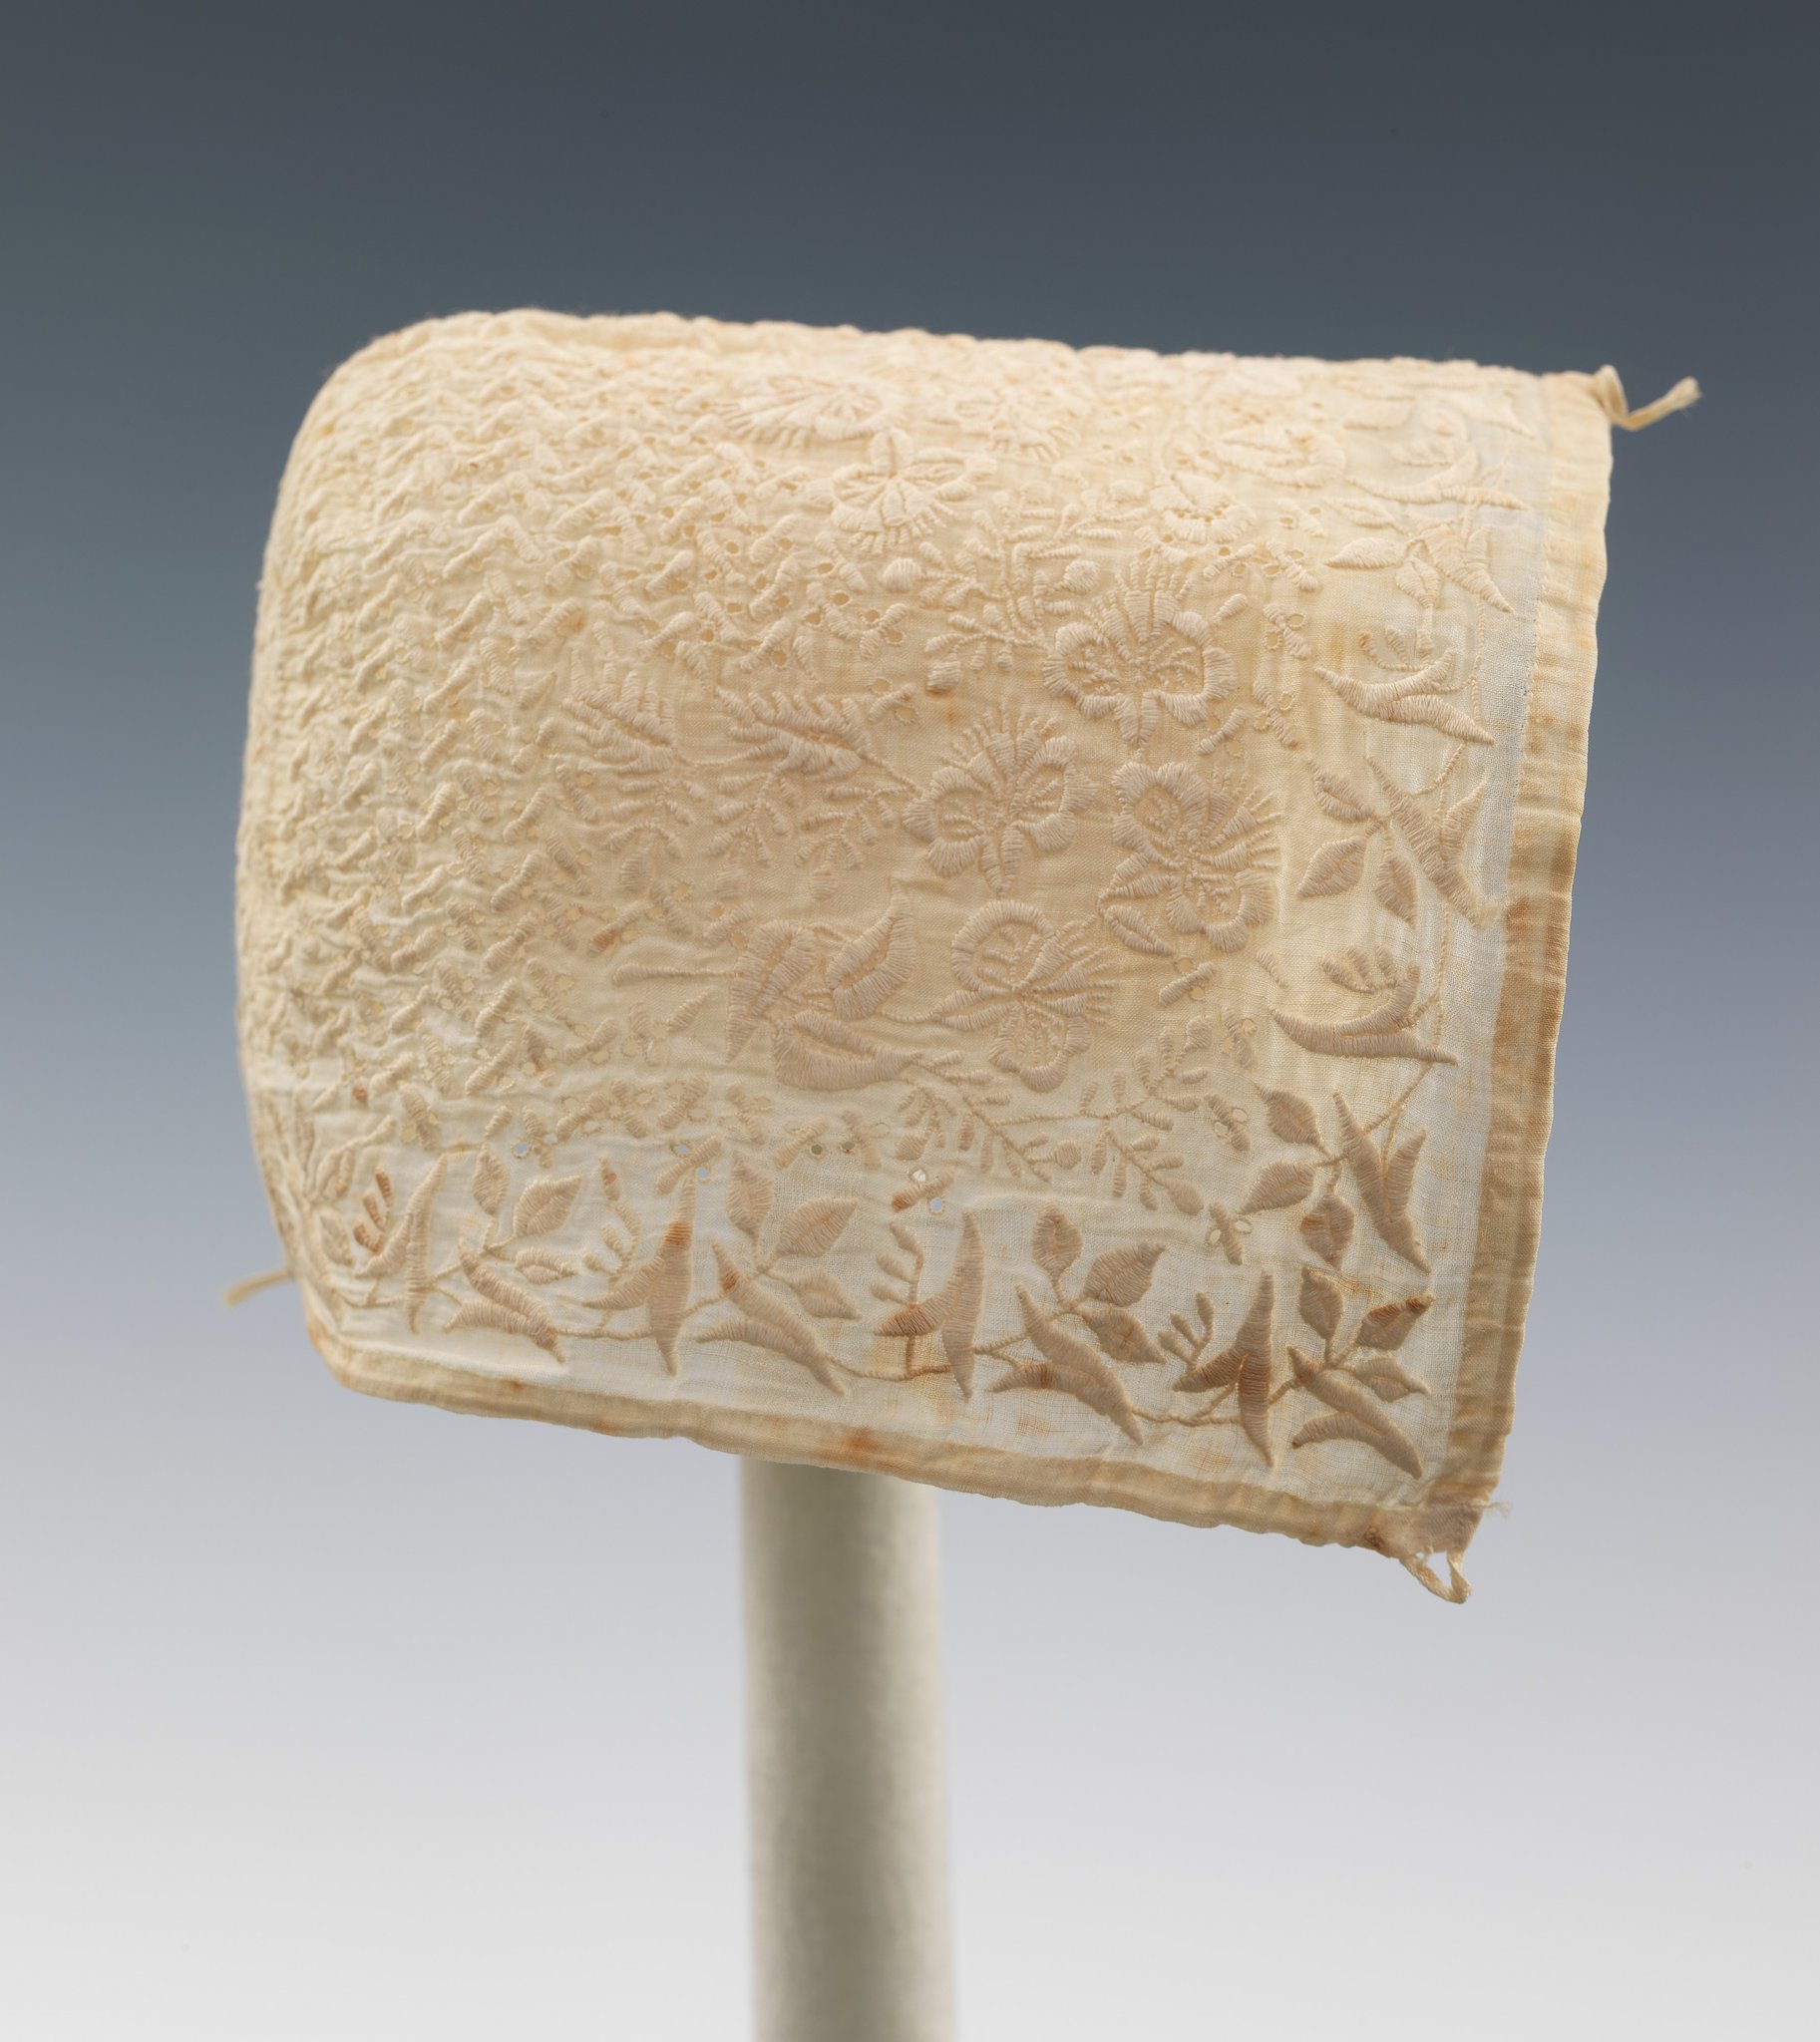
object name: cap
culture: american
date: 1830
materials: cotton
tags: flowers